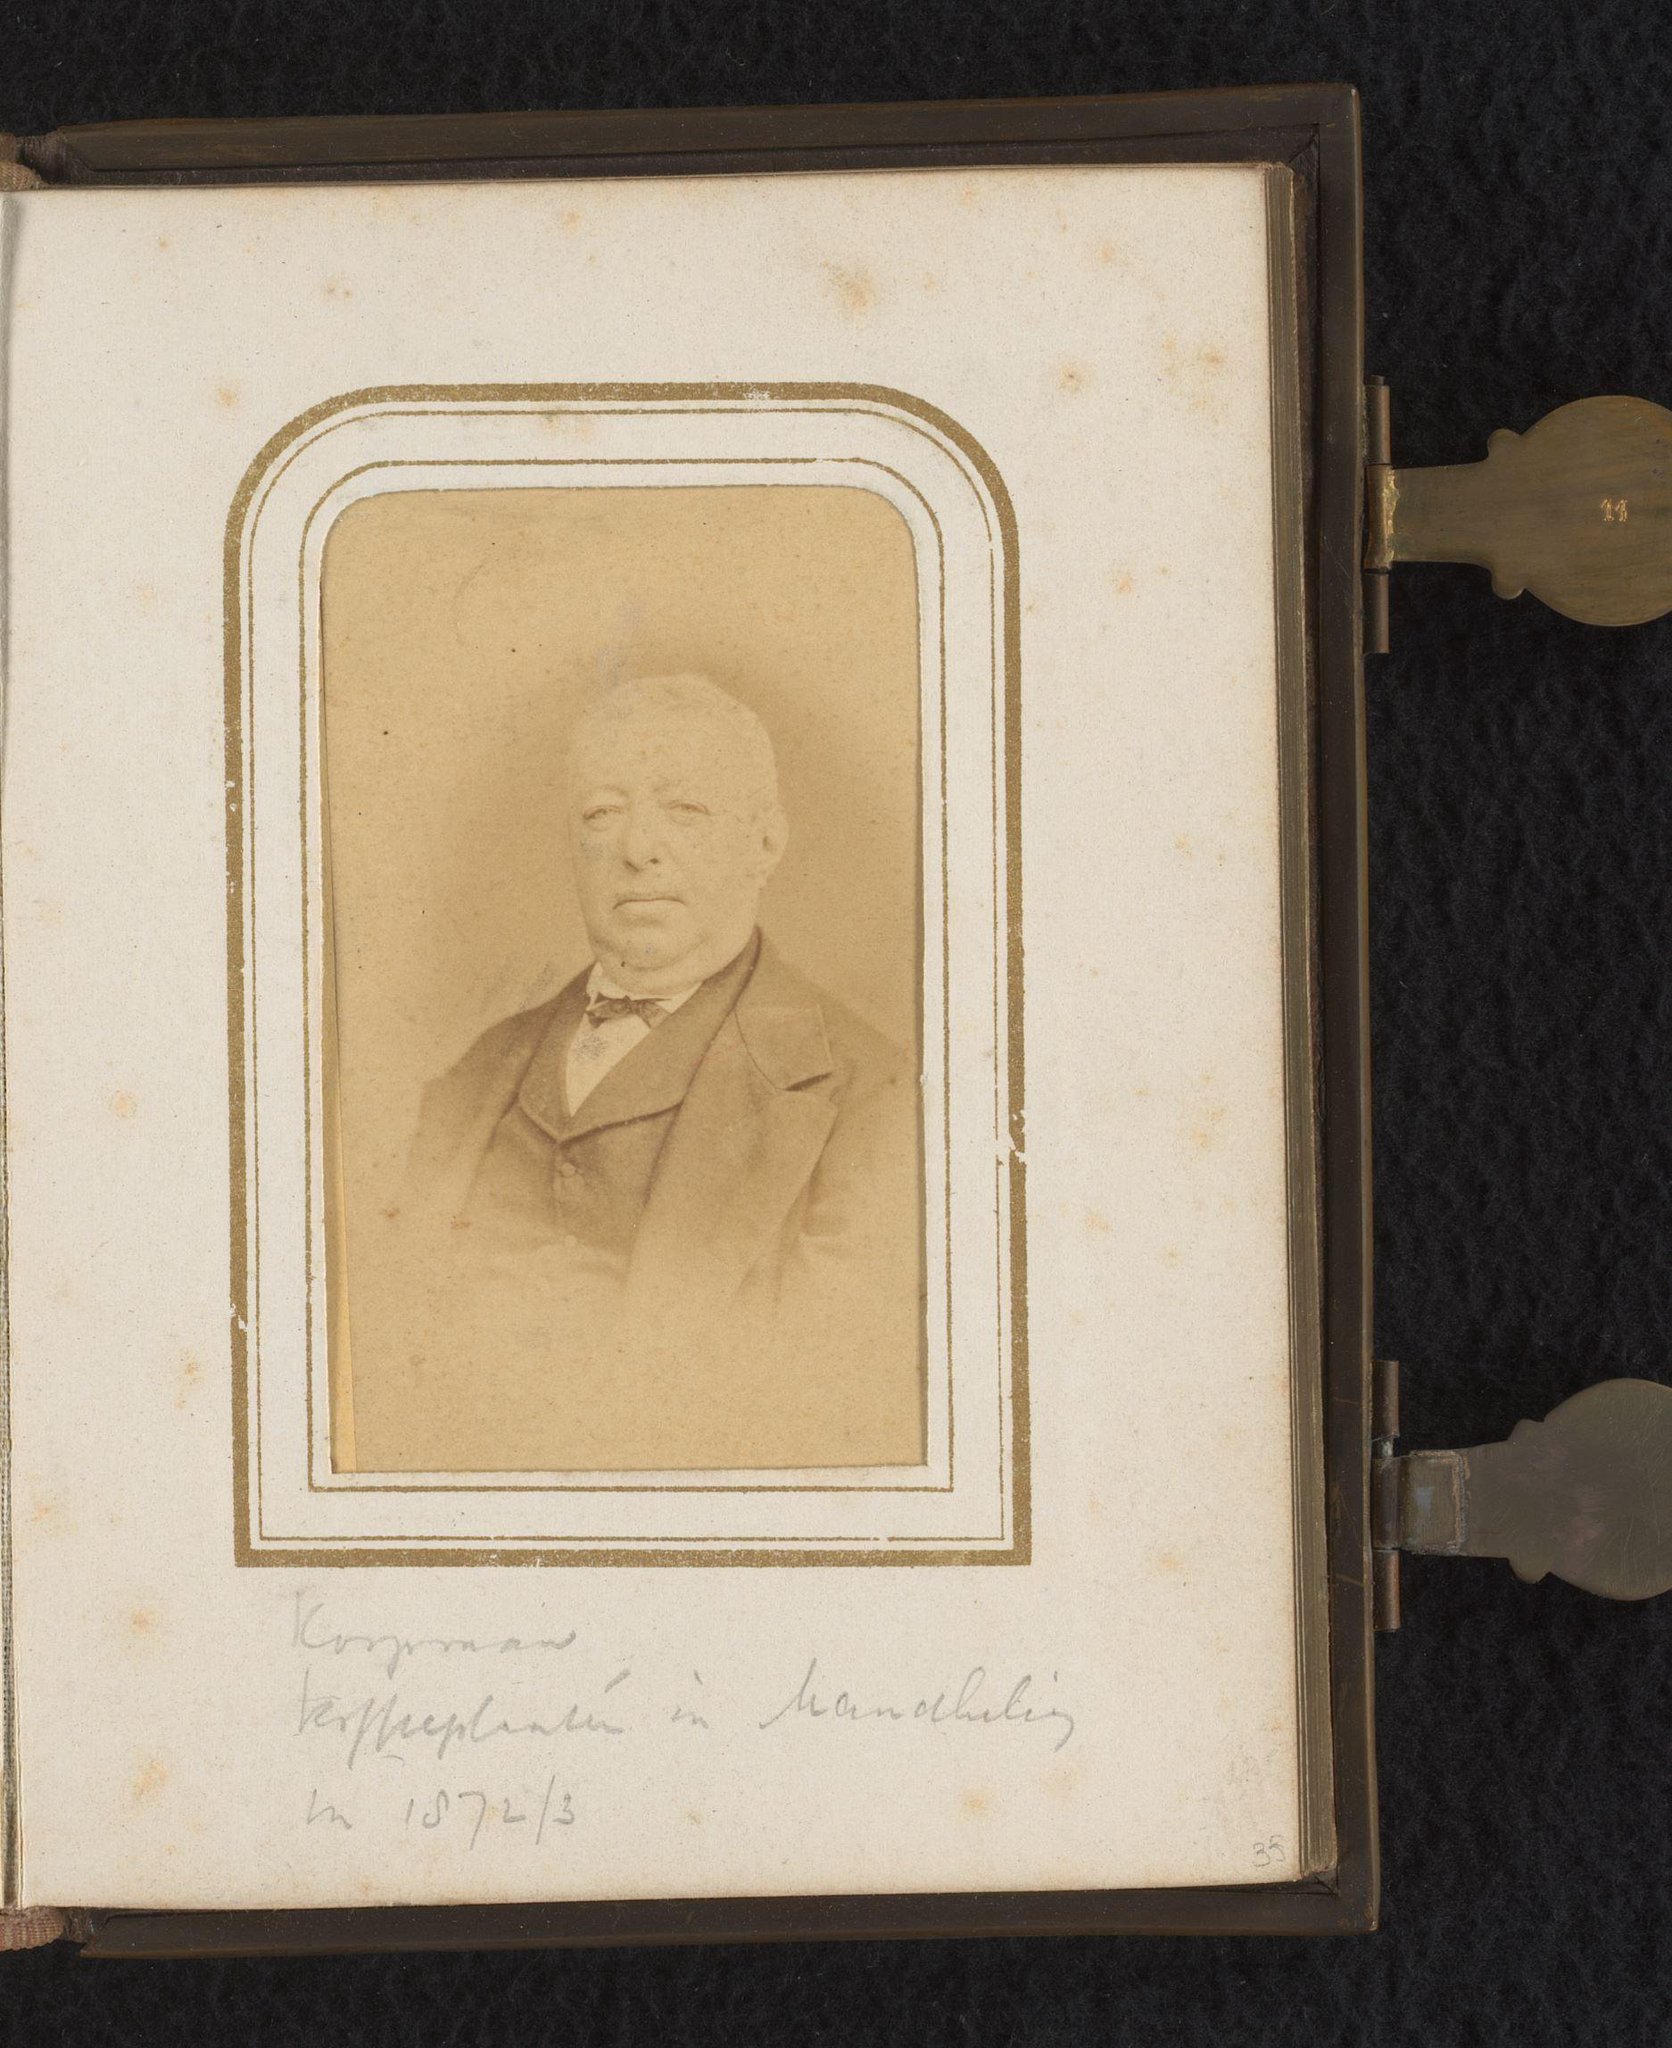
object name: photograph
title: Portret van een man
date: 1872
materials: cardboard, photographic support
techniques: albumen print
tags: adult man, historical persons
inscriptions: annotation: ‘Koopman/ Kofieplanten in [...]/ in 1872/3’, annotation: ‘Koopman/ [Koffiplant/ ...]/ 1872/7-3’, inscription: ‘Woodbury & Page/ Photographers/ Java’